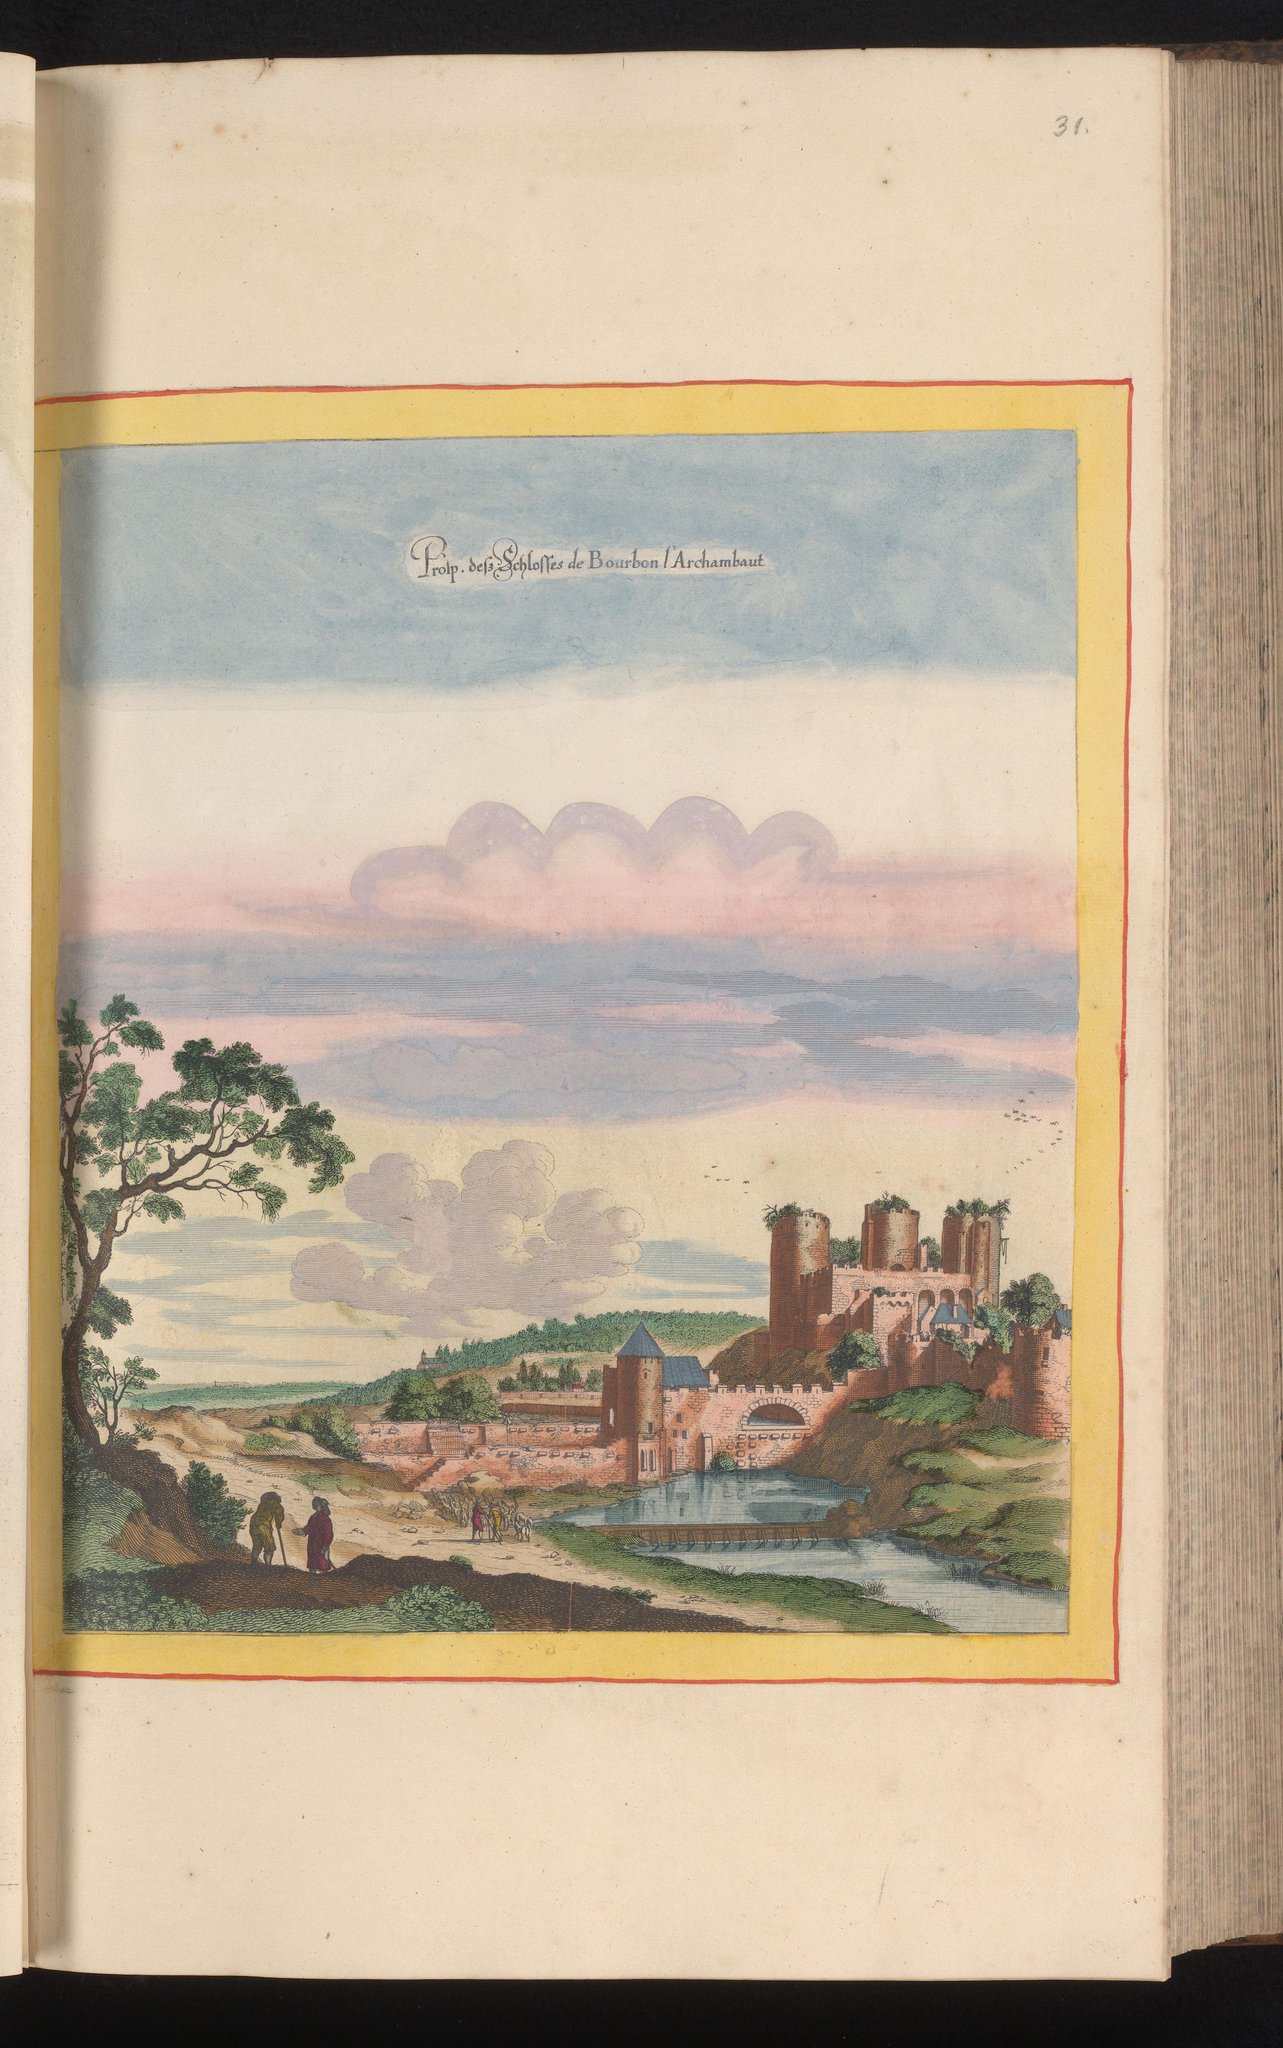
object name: print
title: Prosp. des Schlosses de Bourbon l'Archambaut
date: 1657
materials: paper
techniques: engraving, etching, hand coloring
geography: the hague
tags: castle, maps of cities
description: Prent uit: Zeiller, Martin. Topographia Galliae. 13 dln. Frankfurt: Caspar Merian, 1657, dl. 5, na p. 6. De titel is uit de originele prent gesneden. Boven de gravure is een deel lucht en wolken (bij)geschilderd, waarin de titel gelijmd is.